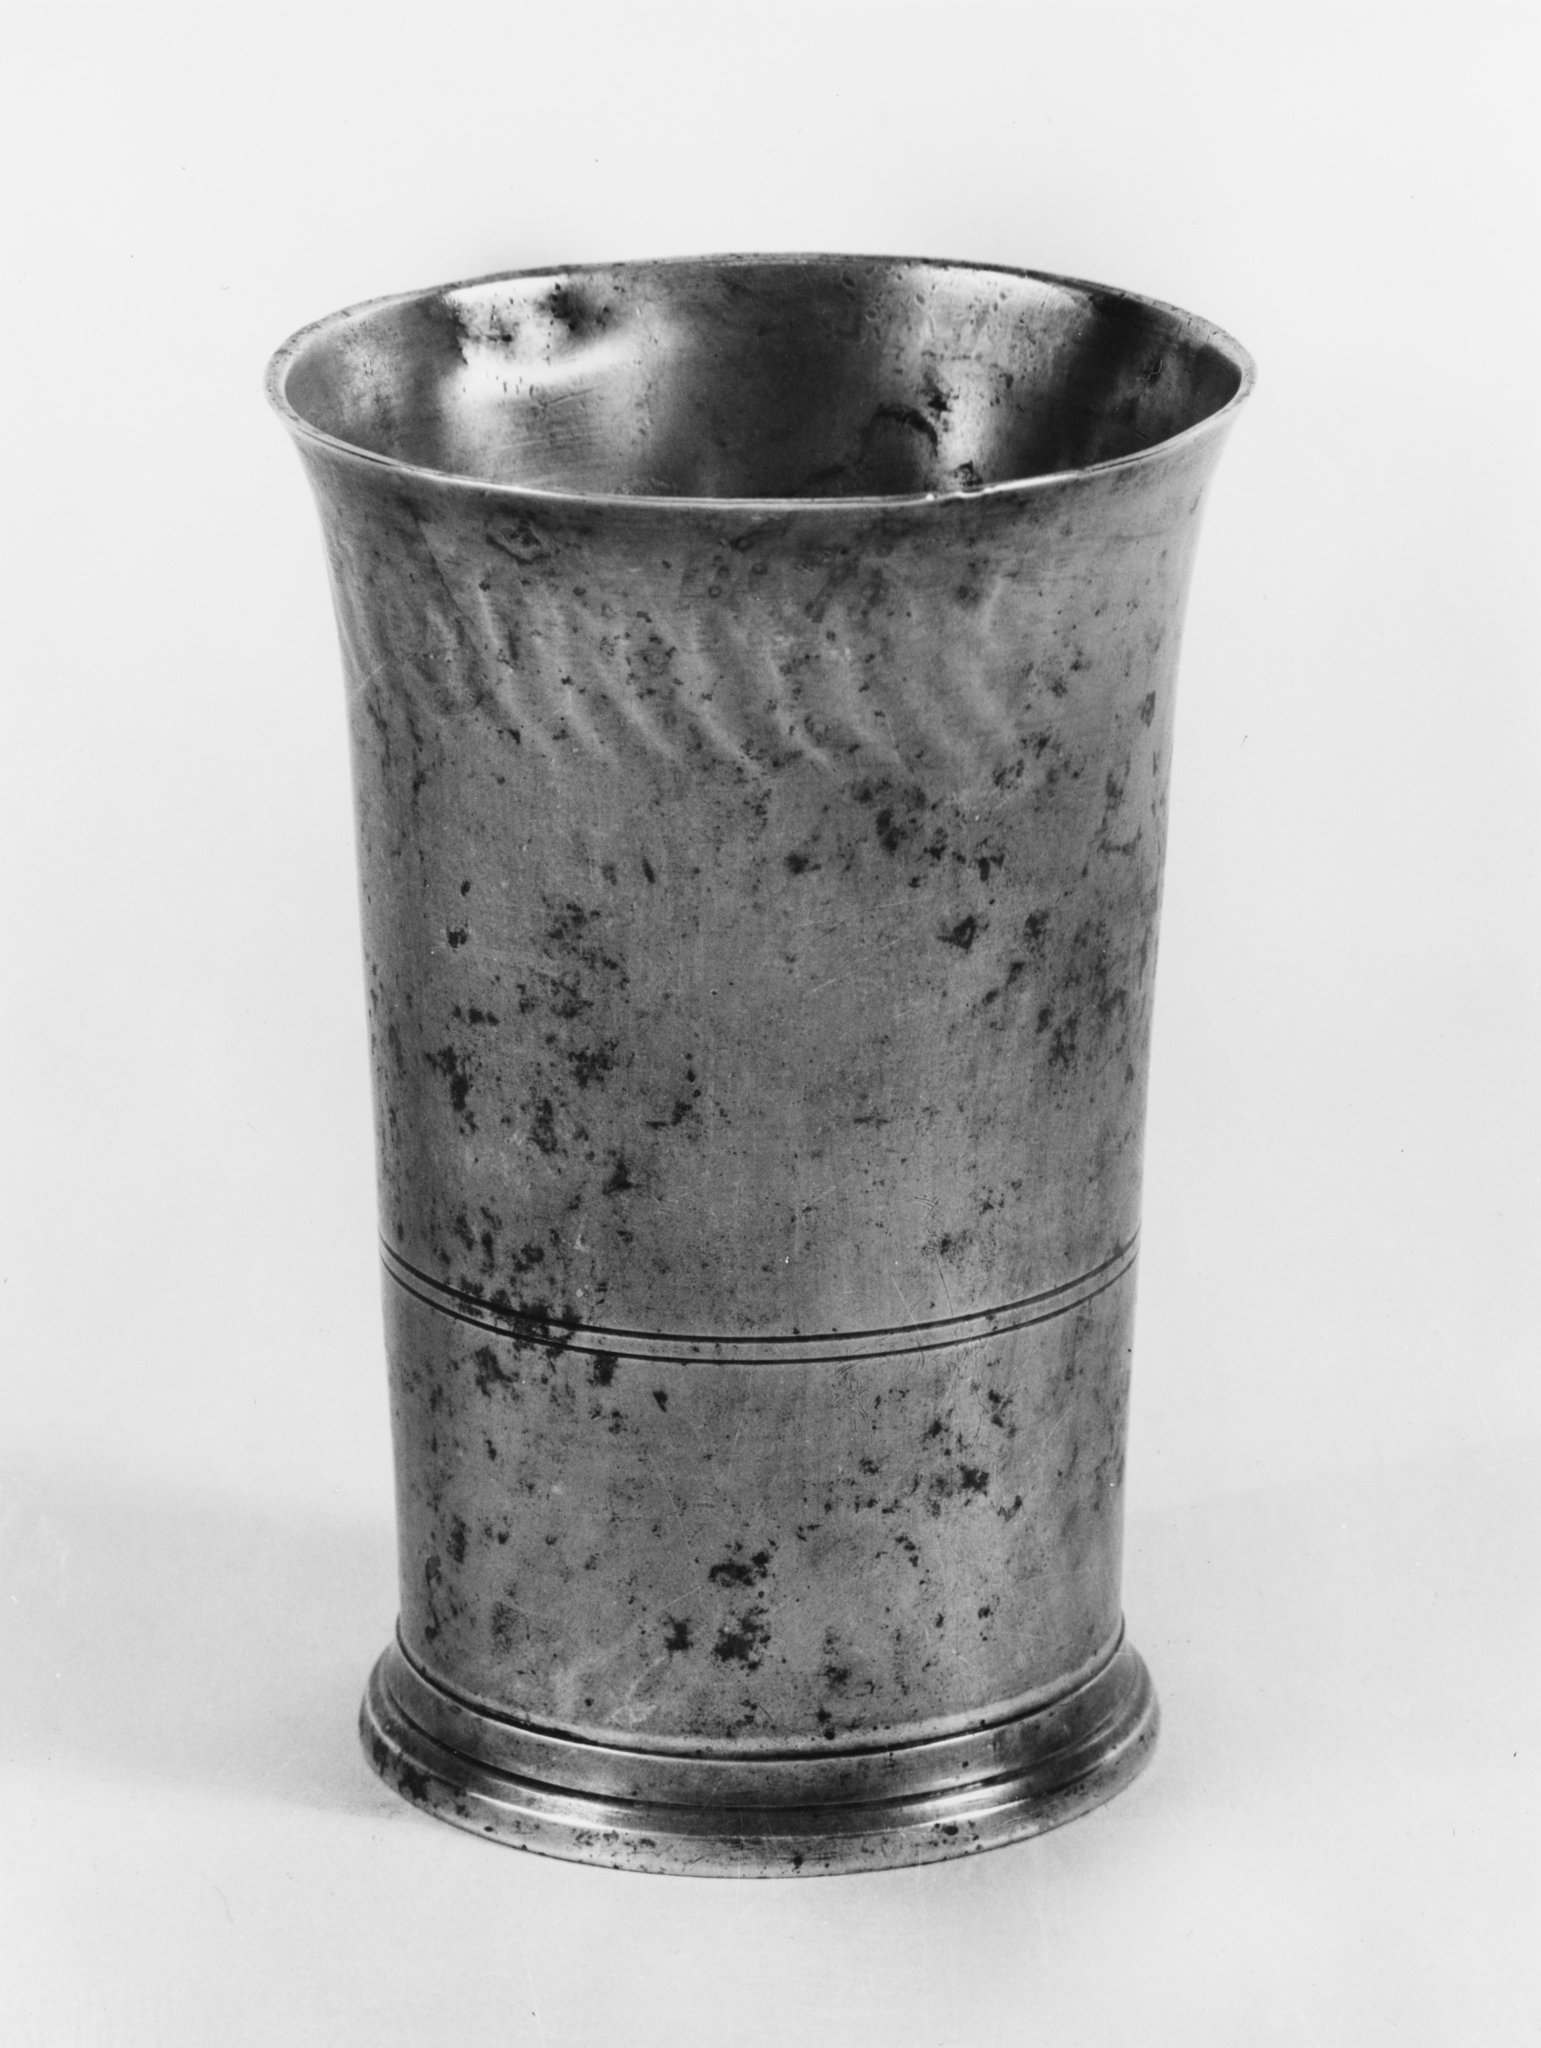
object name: beaker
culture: american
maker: thomas danforth boardman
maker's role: maker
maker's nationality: american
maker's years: 1784-1873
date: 1810-1850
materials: pewter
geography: united states